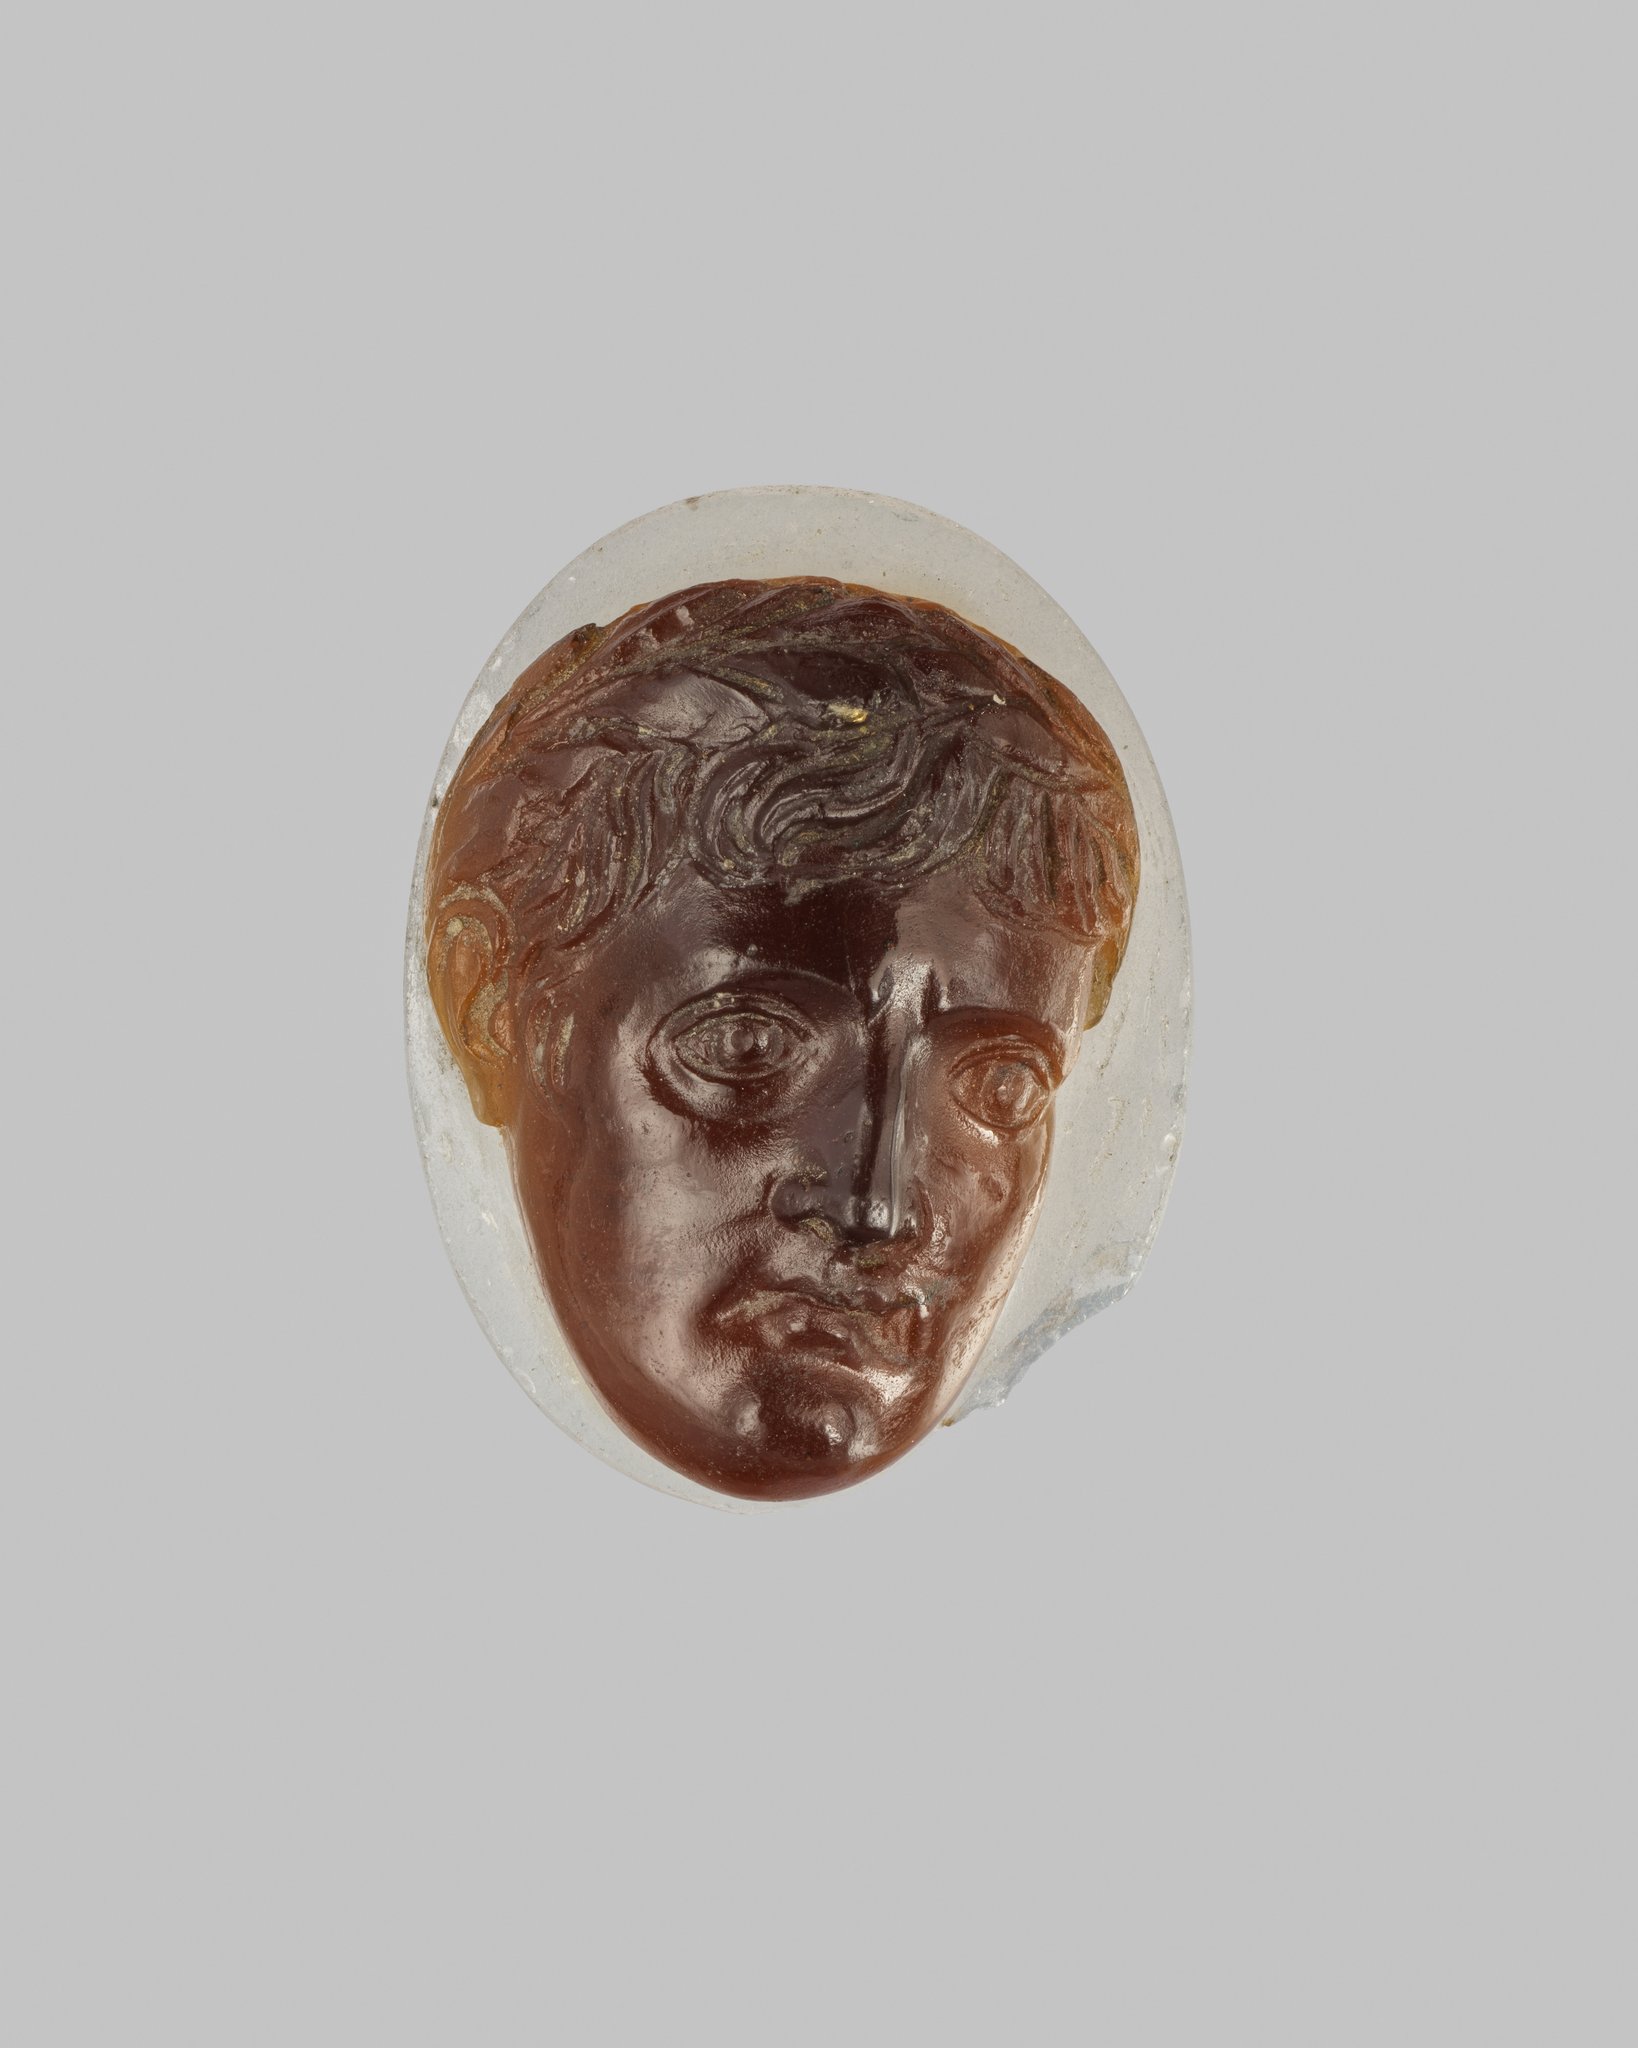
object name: cameo with the head of augustus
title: Glass cameo: head of Augustus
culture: roman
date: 1-33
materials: glass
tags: emperor augustus